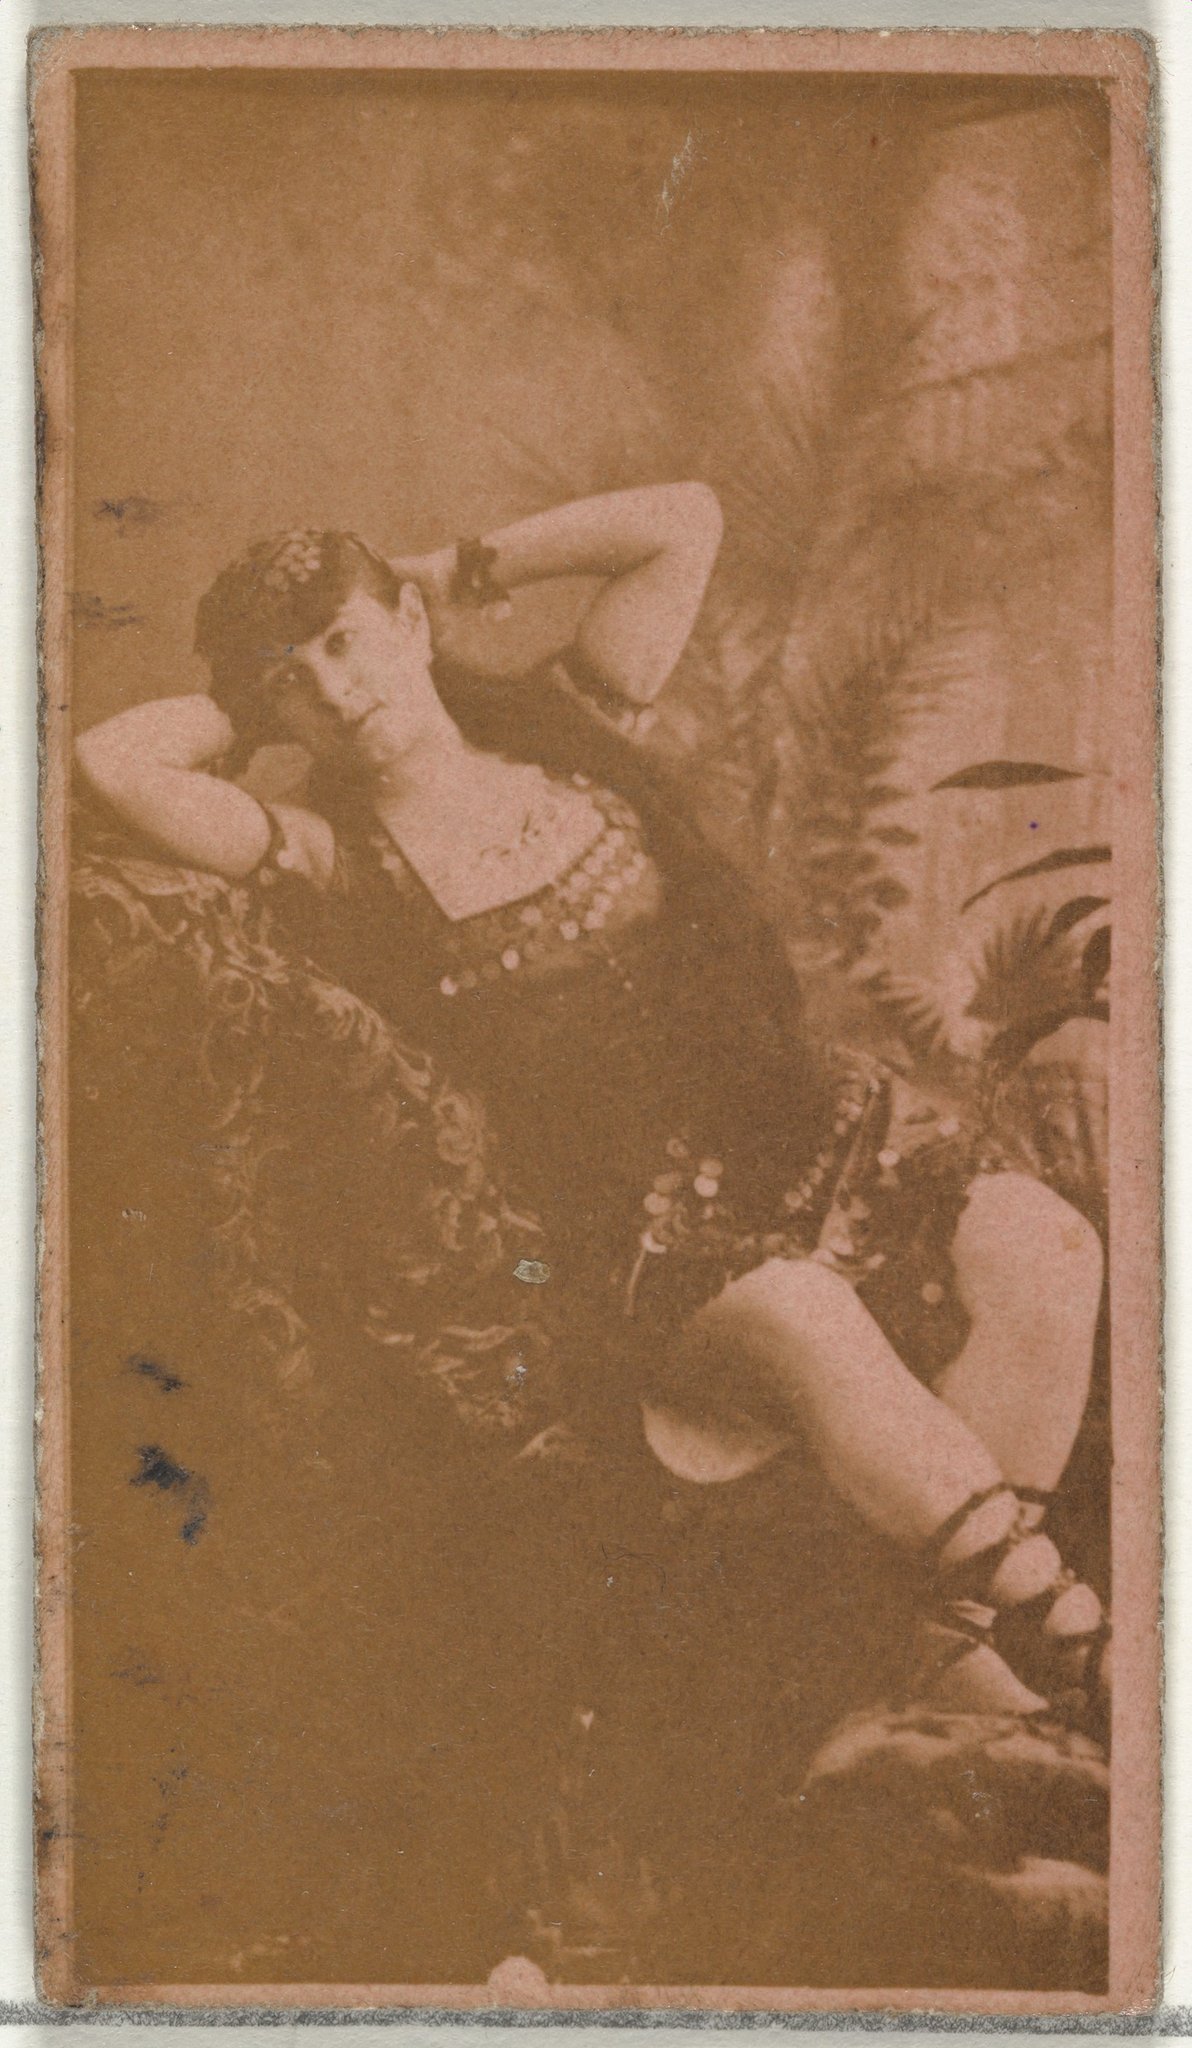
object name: photograph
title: [Reclining actress with hands behind head], from the Actors and Actresses series (N145-8) issued by Duke Sons & Co. to promote Duke Cigarettes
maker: w. duke, sons & co.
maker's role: publisher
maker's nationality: american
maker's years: 1870-1920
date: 1891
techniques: albumen silver print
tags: portraits,women,actresses